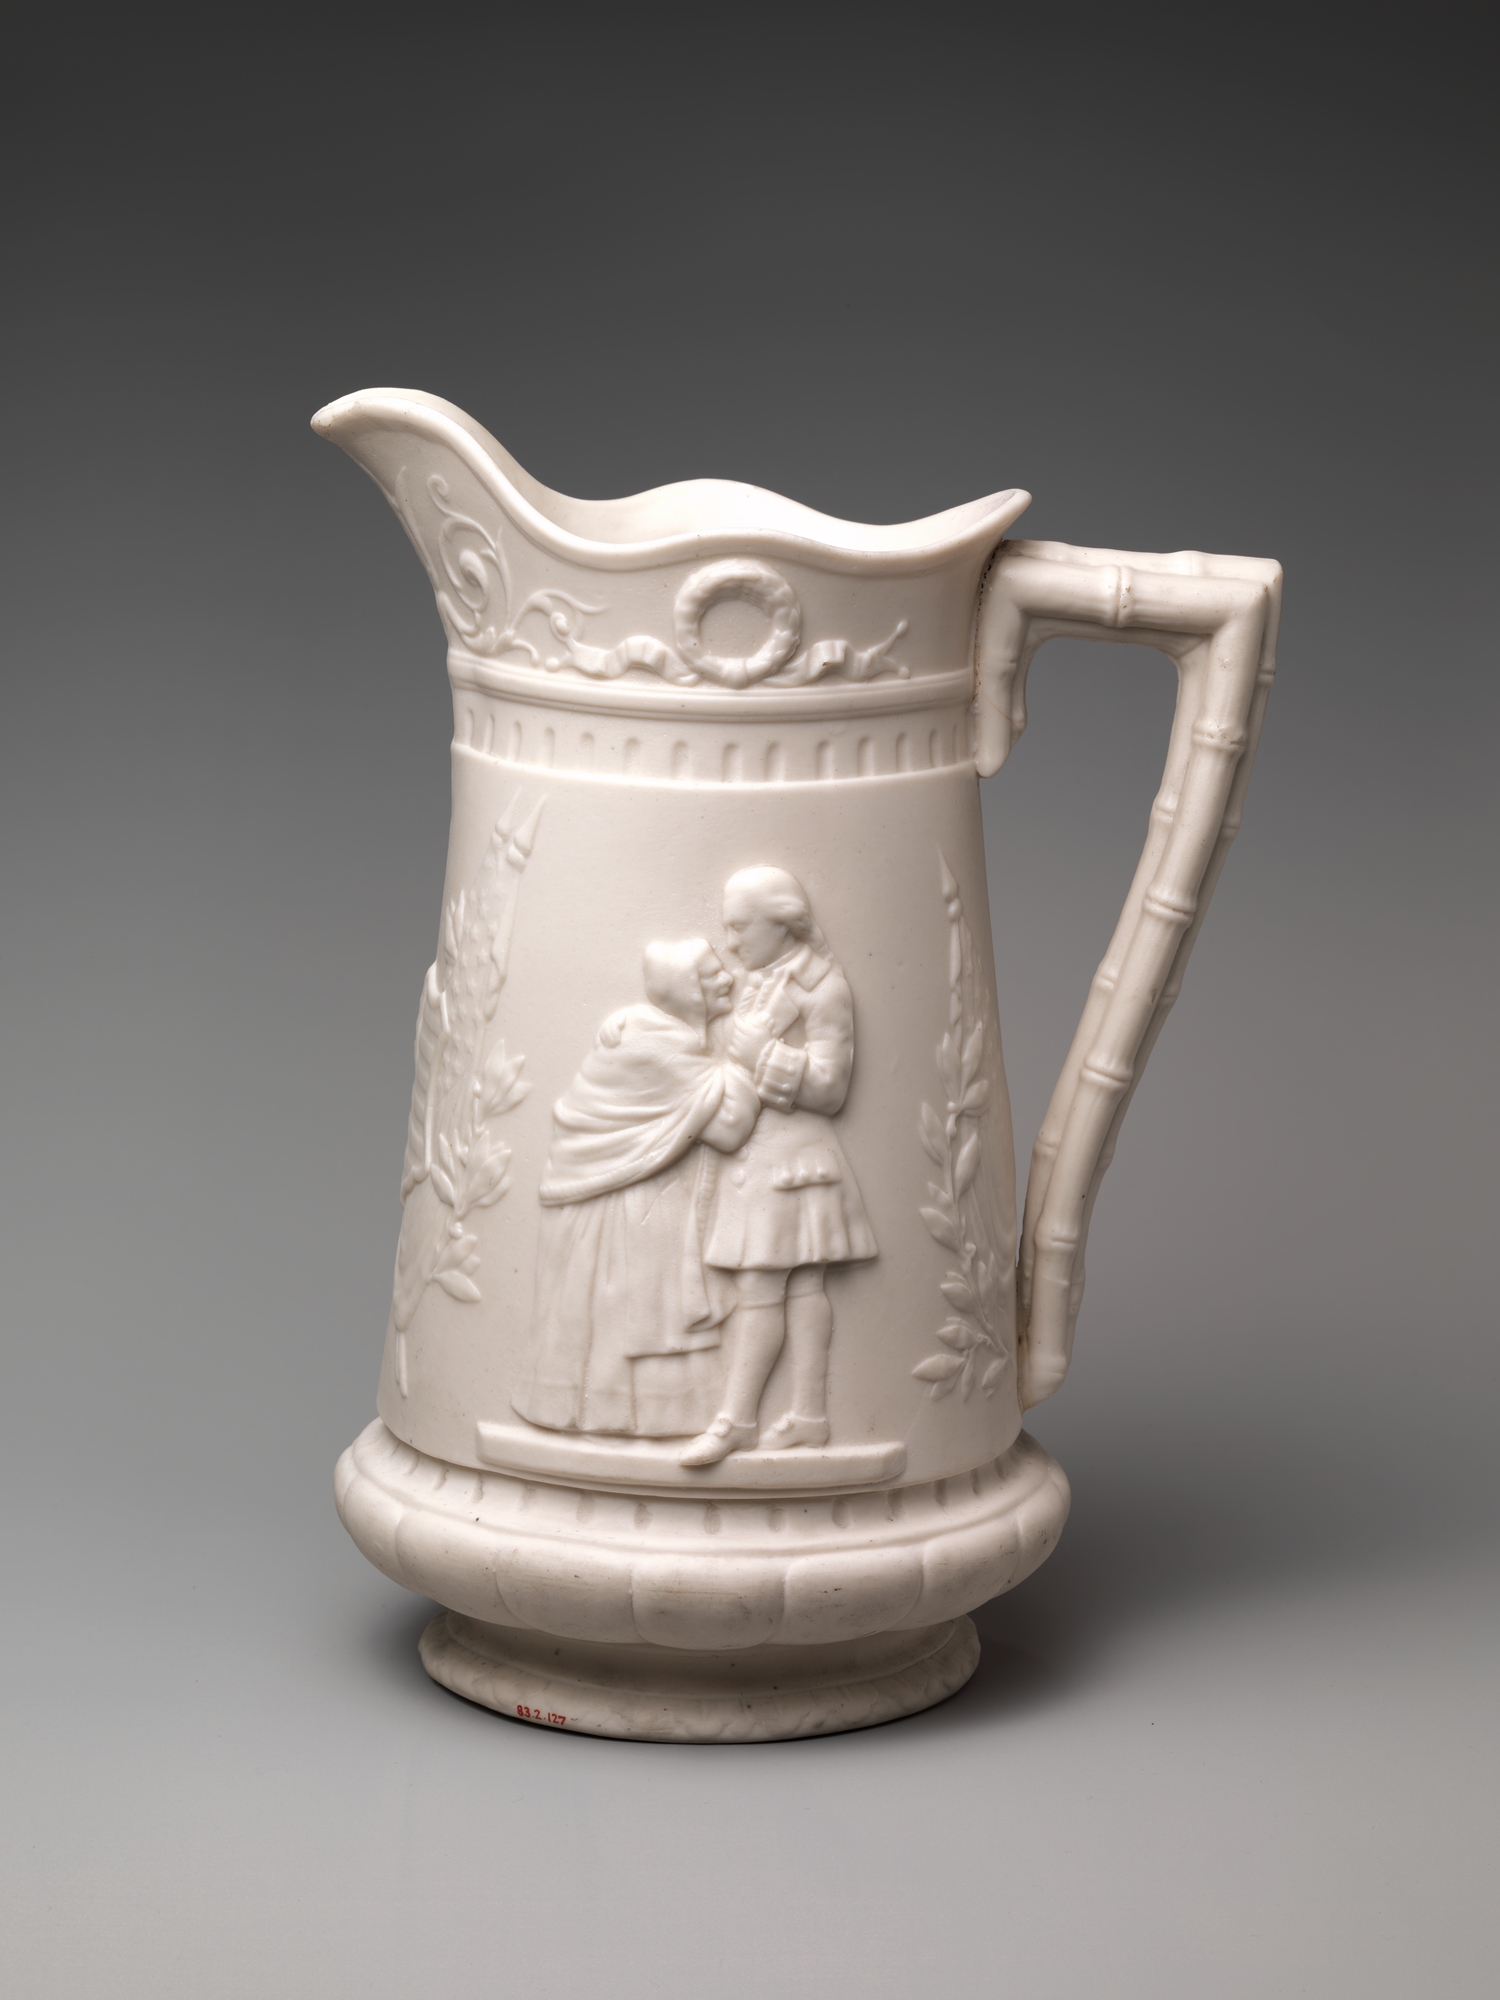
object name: jug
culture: british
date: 1870-1900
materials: porcelain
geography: england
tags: george washington,men,mothers,women